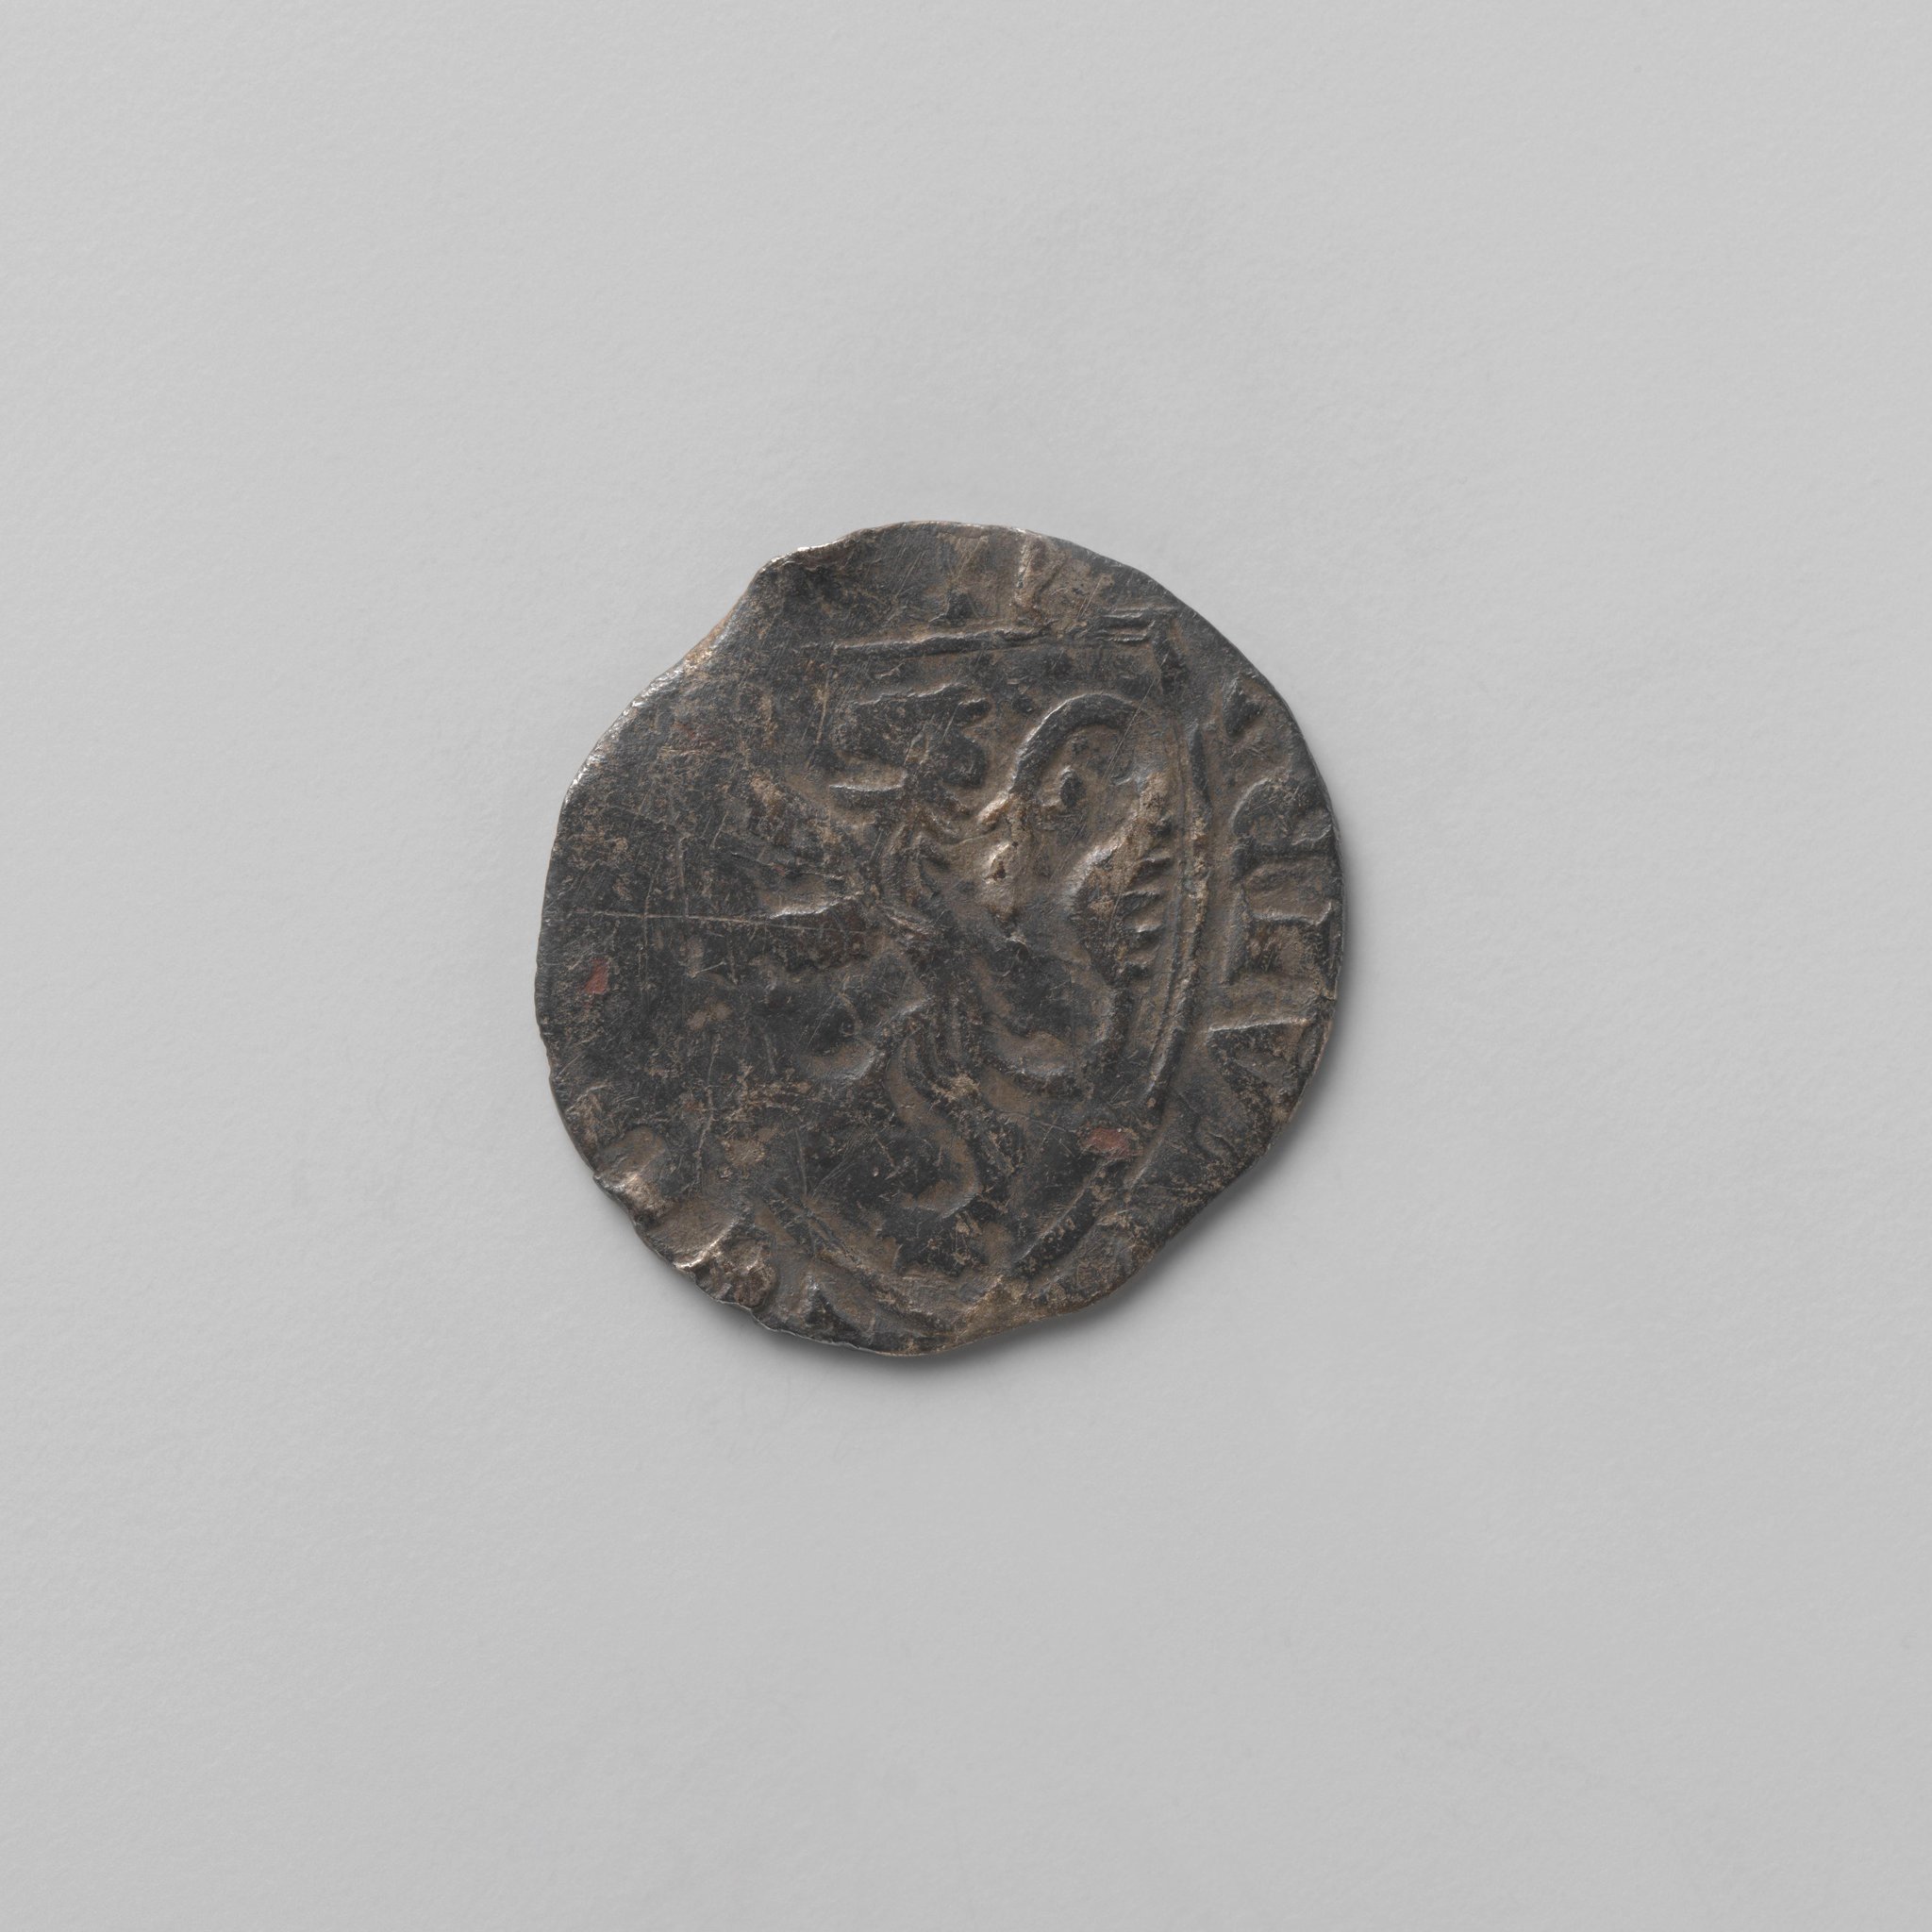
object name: coin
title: penning van Jan van Kuinre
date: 1300-1310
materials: silver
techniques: striking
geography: kuinre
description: Zilveren munt. Voorzijde: wapenschild met leeuw. Keerzijde: lang kruis.